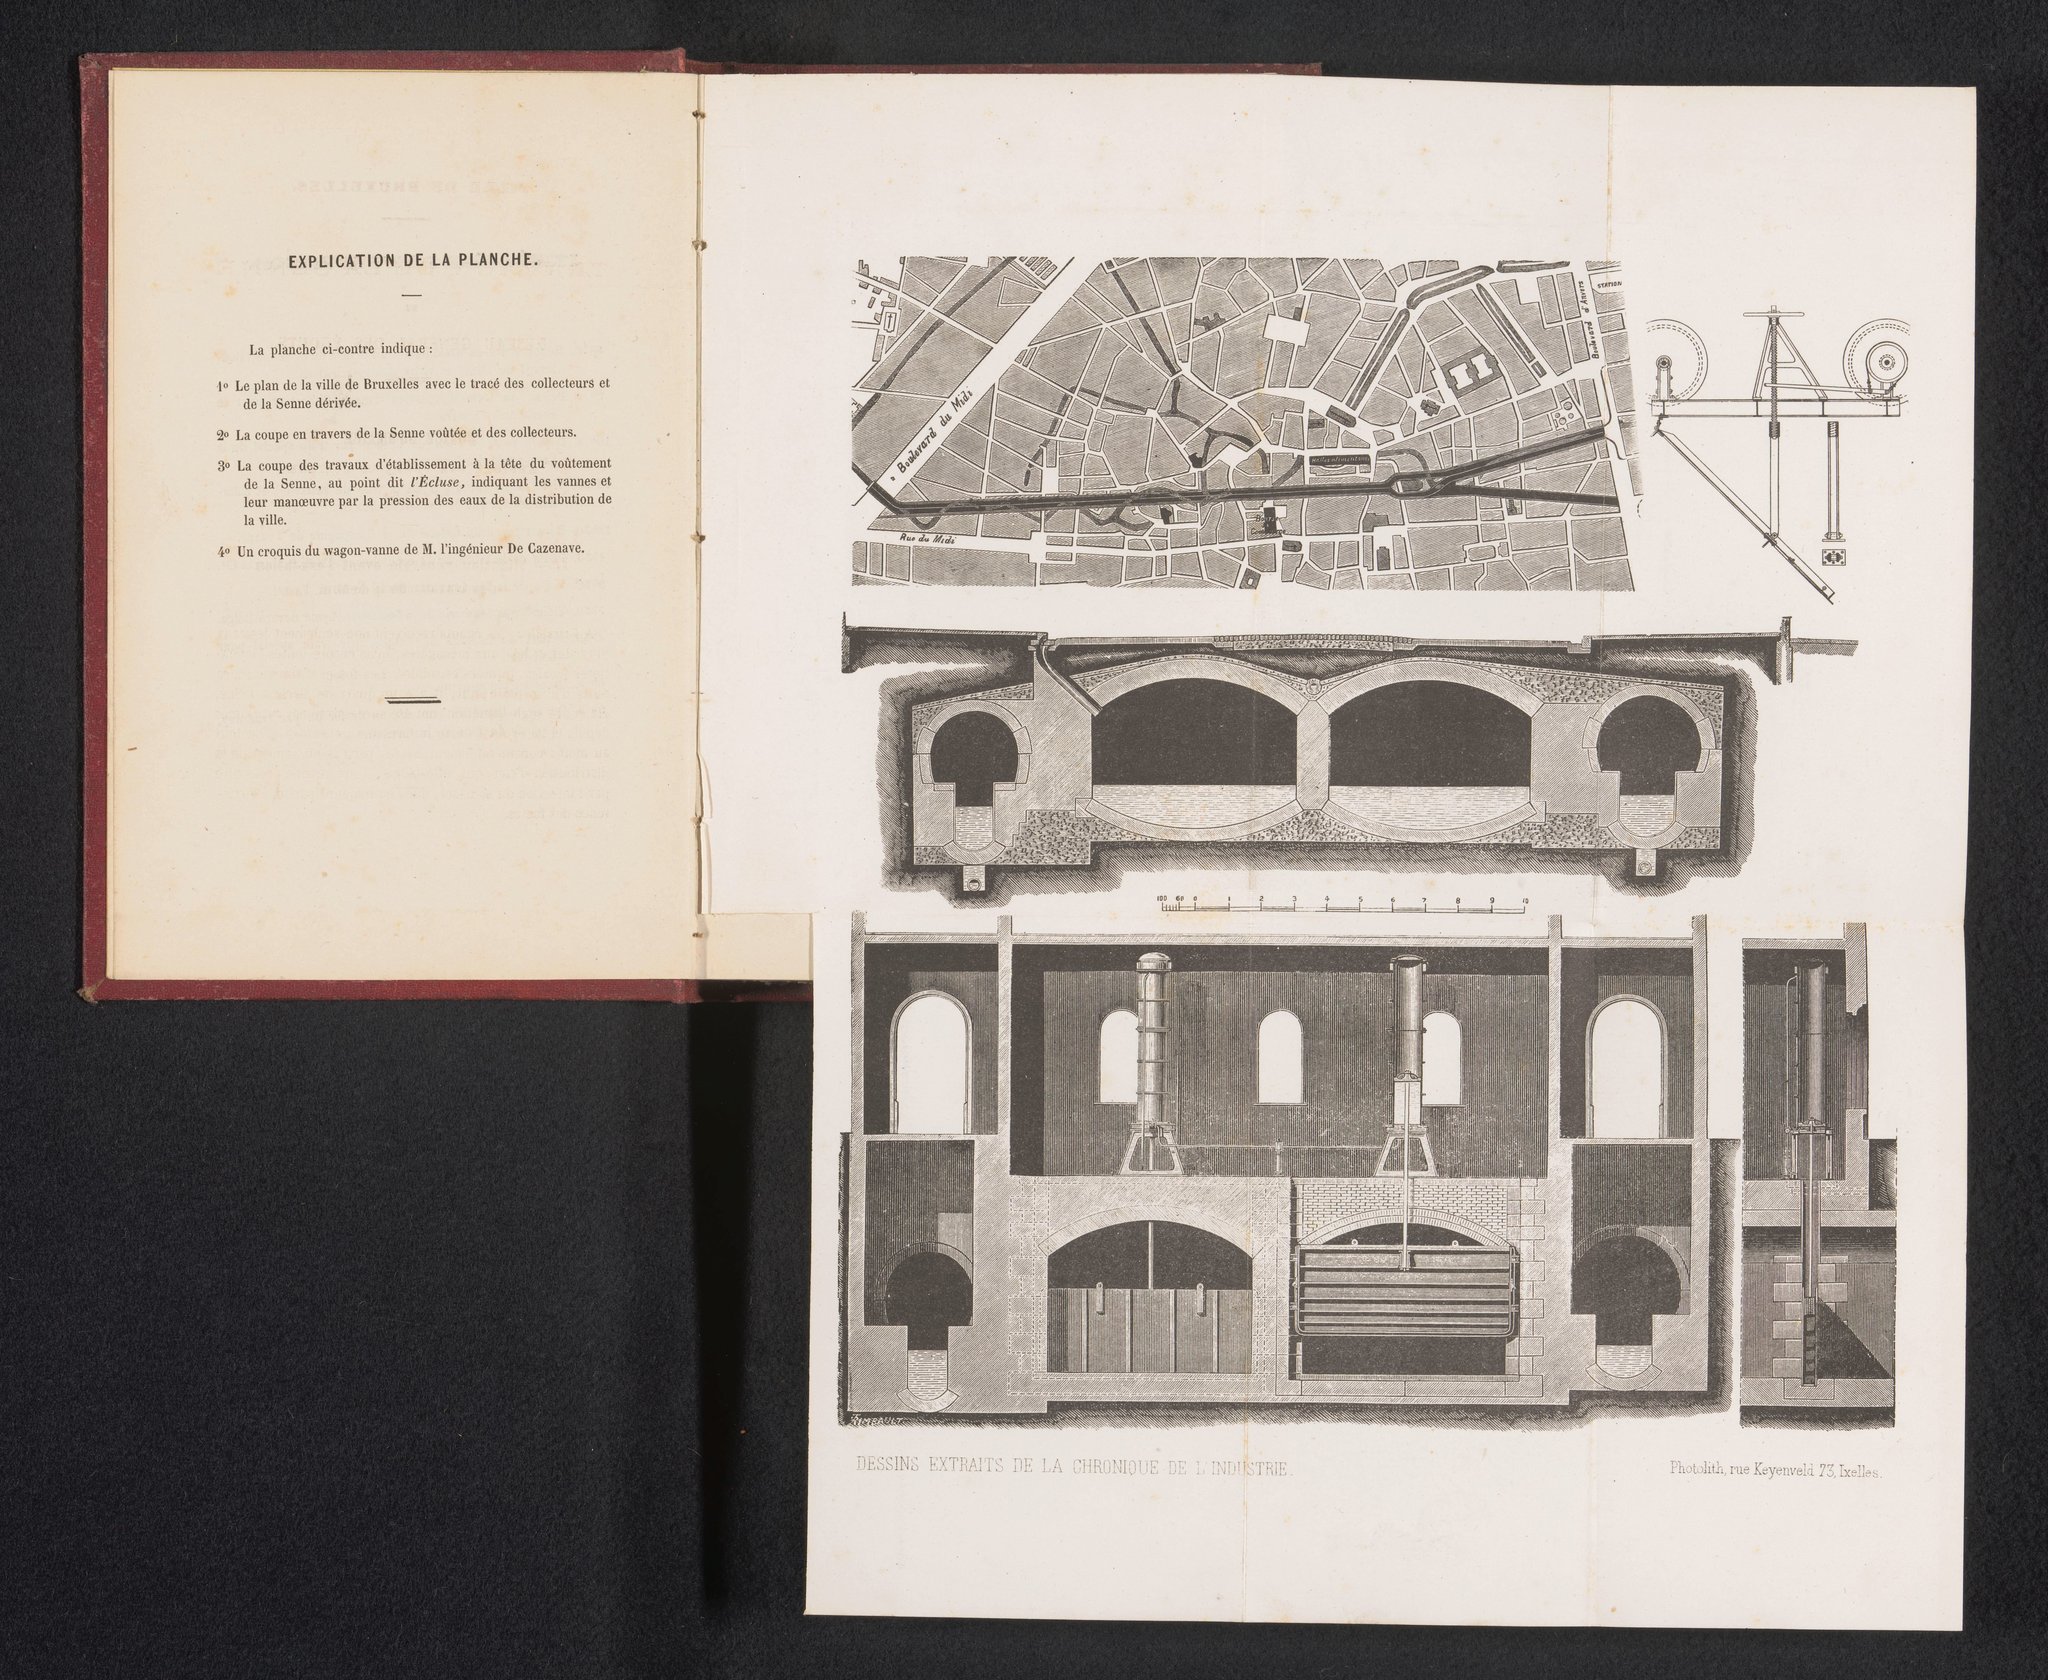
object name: photomechanical print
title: Ontwerp van een ondergronds waterstelsel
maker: Anonymous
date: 1871-1876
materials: paper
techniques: photolithography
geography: brussels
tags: plan ~ architecture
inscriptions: inscription: ‘Photolith, rue Keyenveld 73, Ixelles’, inscription: ‘Rimbault’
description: Prent op vierde ongenummerde pagina na titelpagina.